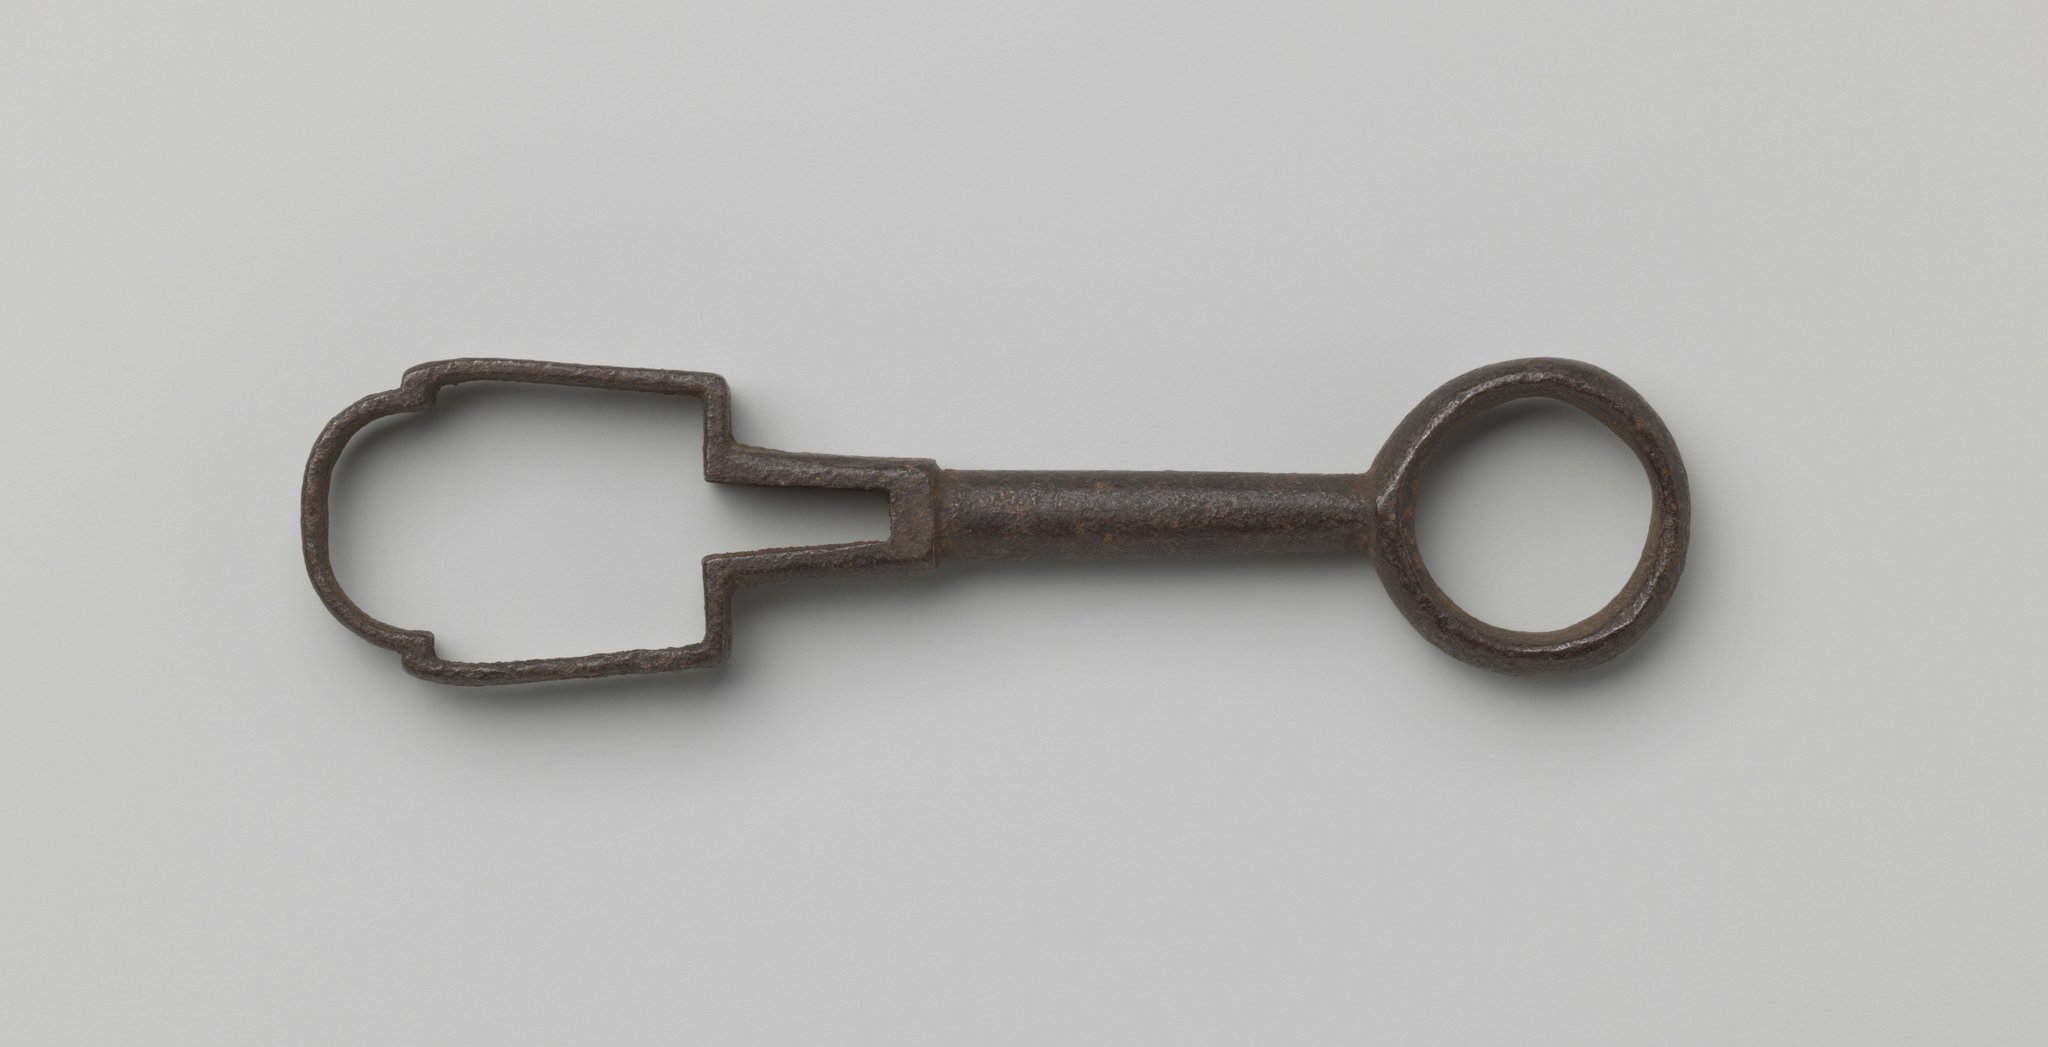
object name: key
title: Sleutel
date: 1400-1950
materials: iron